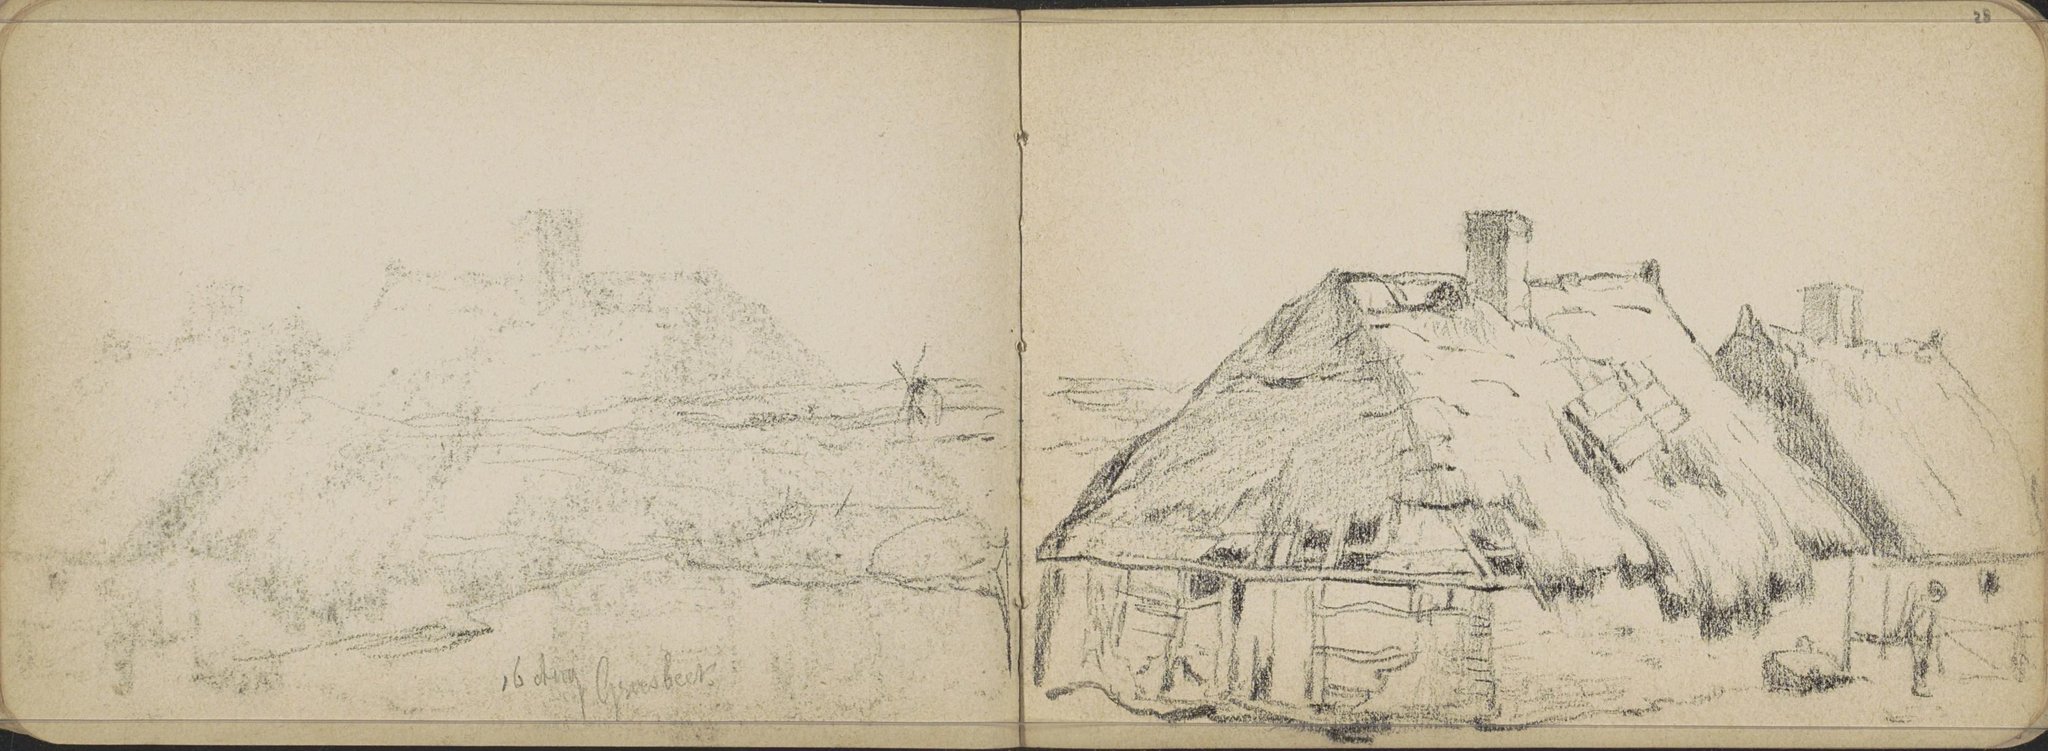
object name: sketchbook leaf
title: Boerderij te Groesbeek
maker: willem cornelis rip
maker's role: draughtsman, painter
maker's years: 1856-1922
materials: chalk, paper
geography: groesbeek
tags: farm (building)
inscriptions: date and inscription: ‘16 Aug/ Groesbeek’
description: Blad 27 verso en 28 recto uit een schetsboek met 44 bladen.